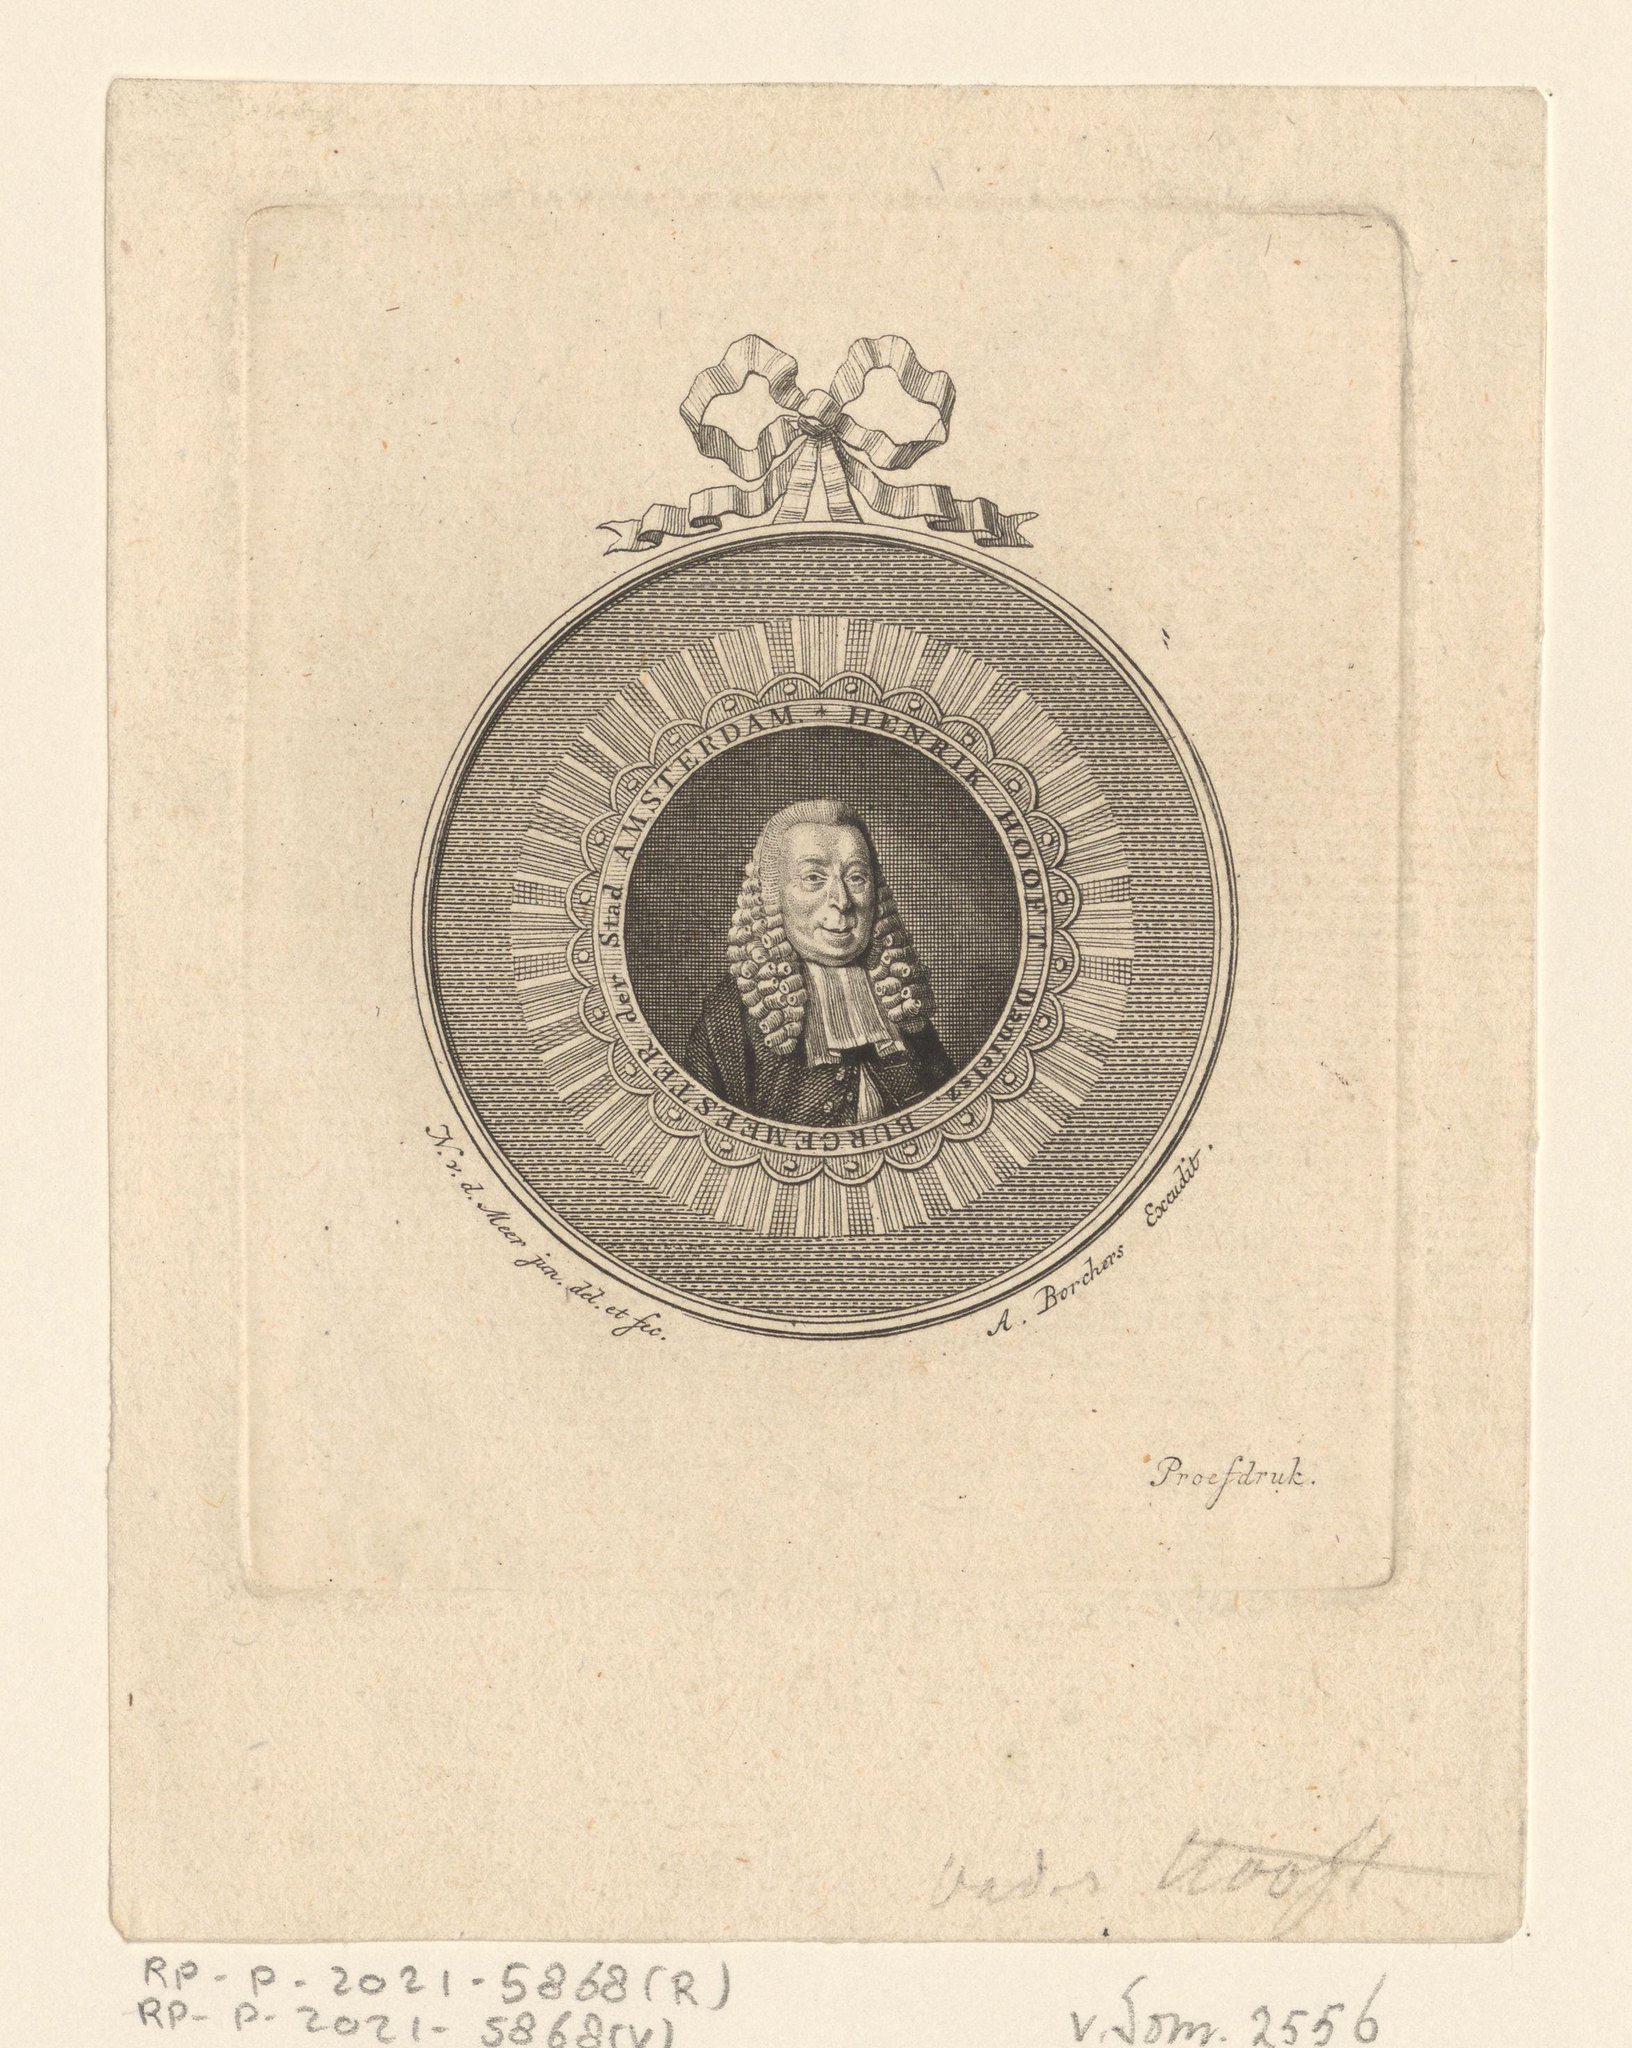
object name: print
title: Portret van Hendrik Danielsz. Hooft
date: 1774-1797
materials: paper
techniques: etching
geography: amsterdam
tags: hendrik danielsz. hooft, mayor, burgomaster, historical persons